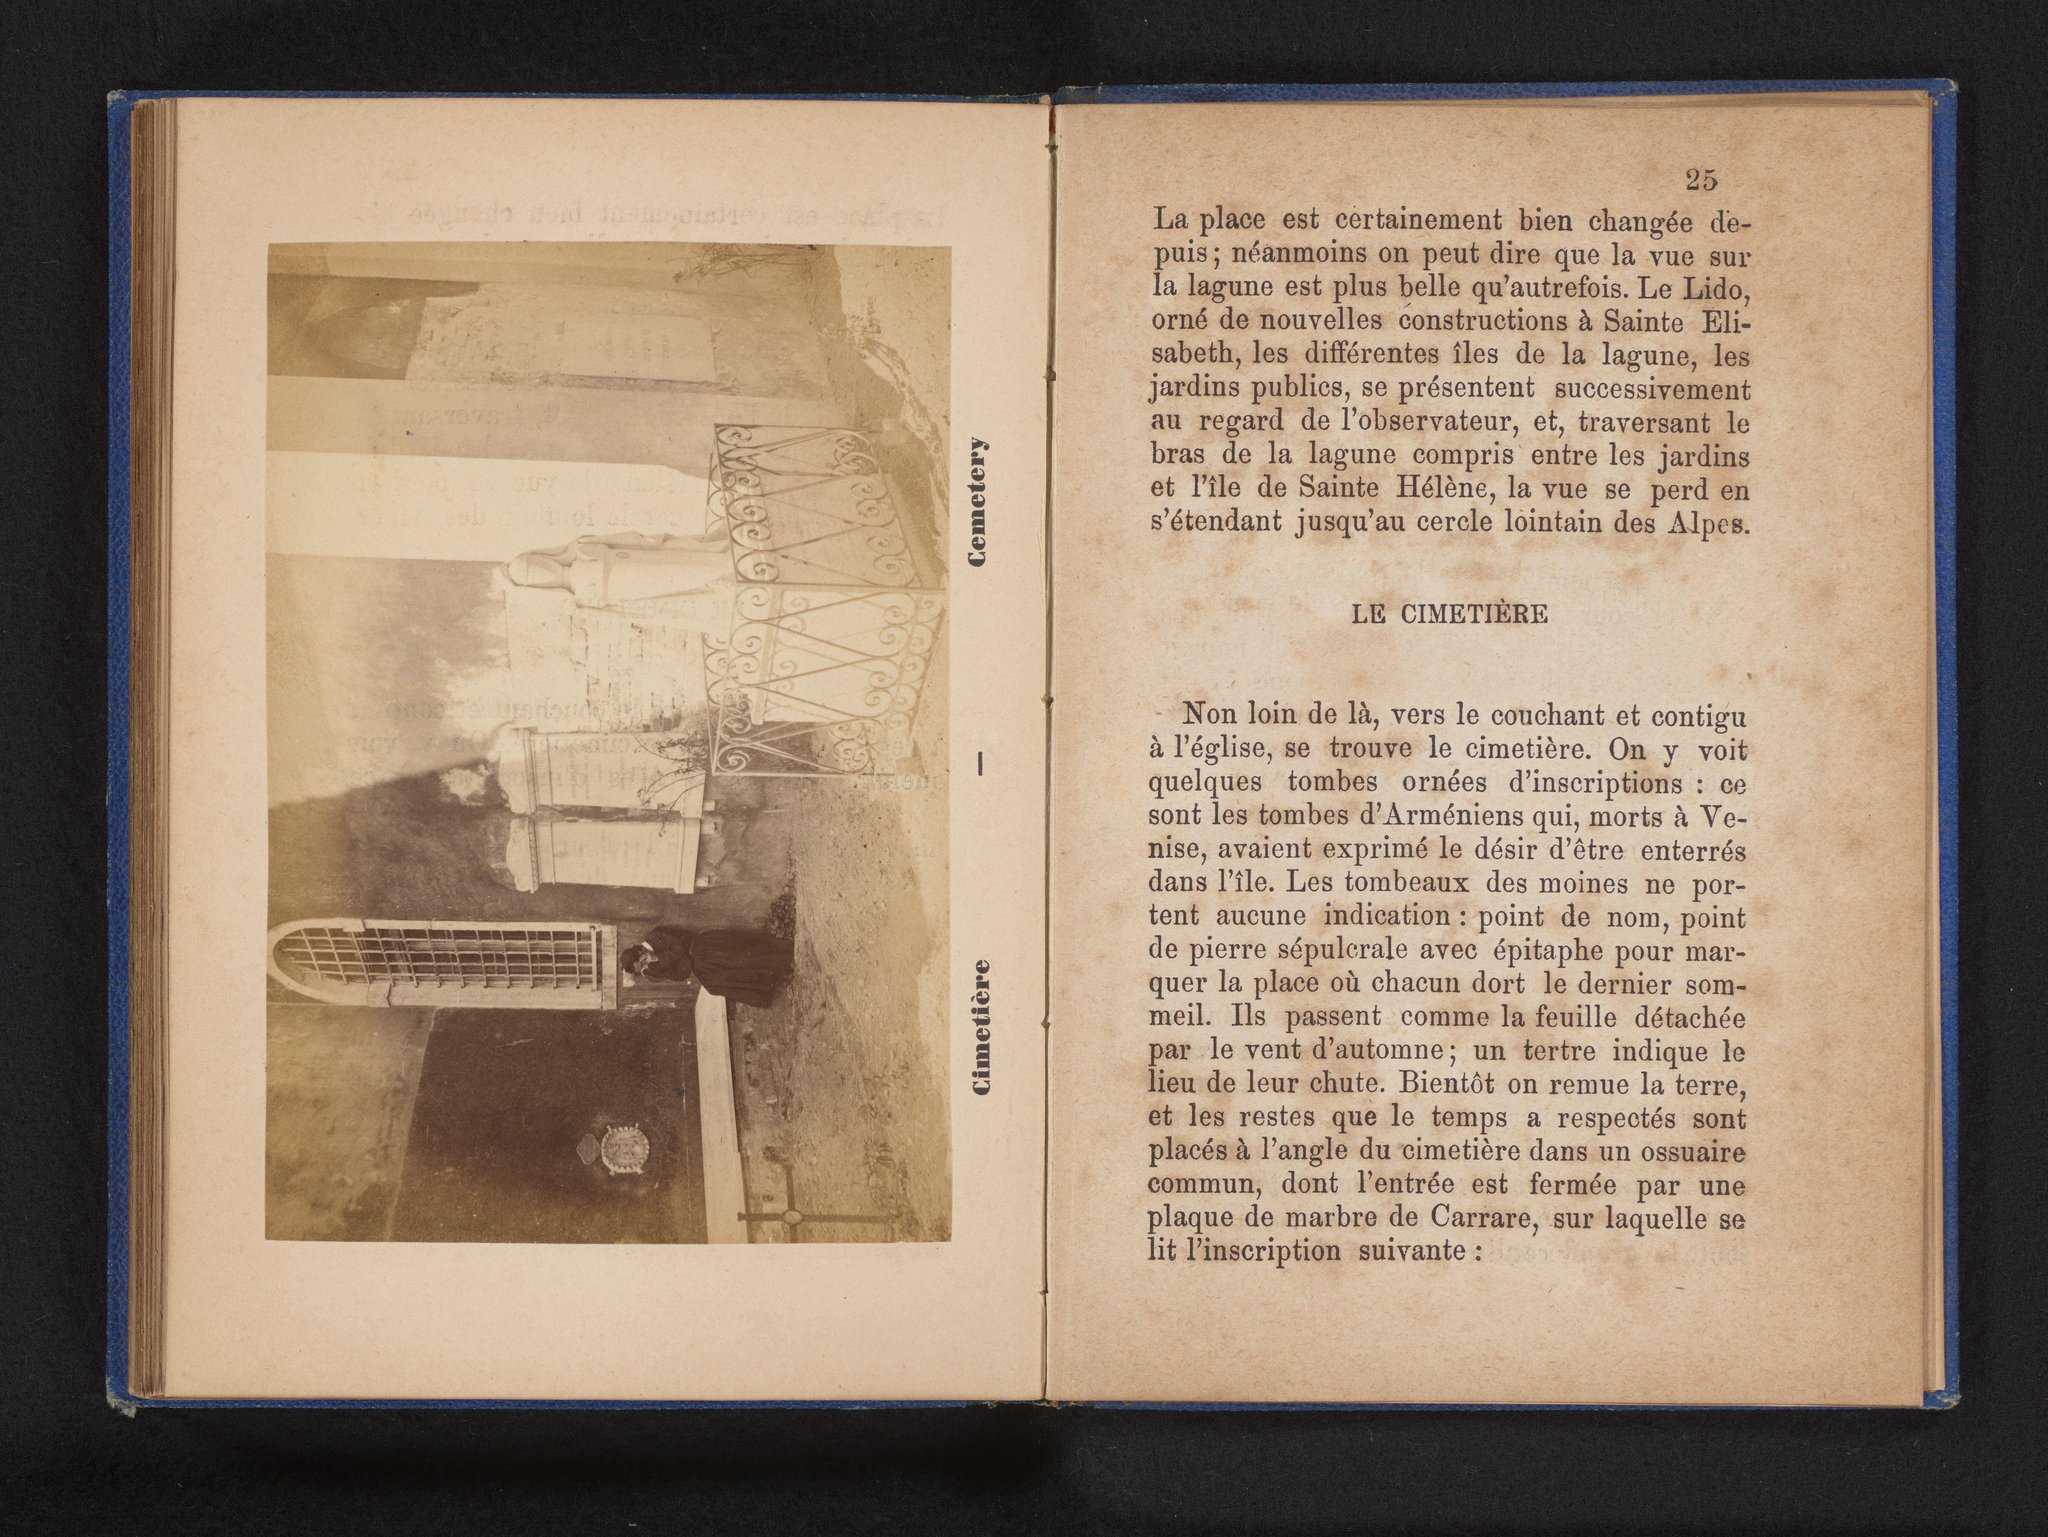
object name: photograph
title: Begraafplaats van San Lazzaro degli Armeni, Venetië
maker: Anonymous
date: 1874-1879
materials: paper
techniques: albumen print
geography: venice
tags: churchyard, cemetery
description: Foto op ongenummerde pagina tegenover pagina 25.